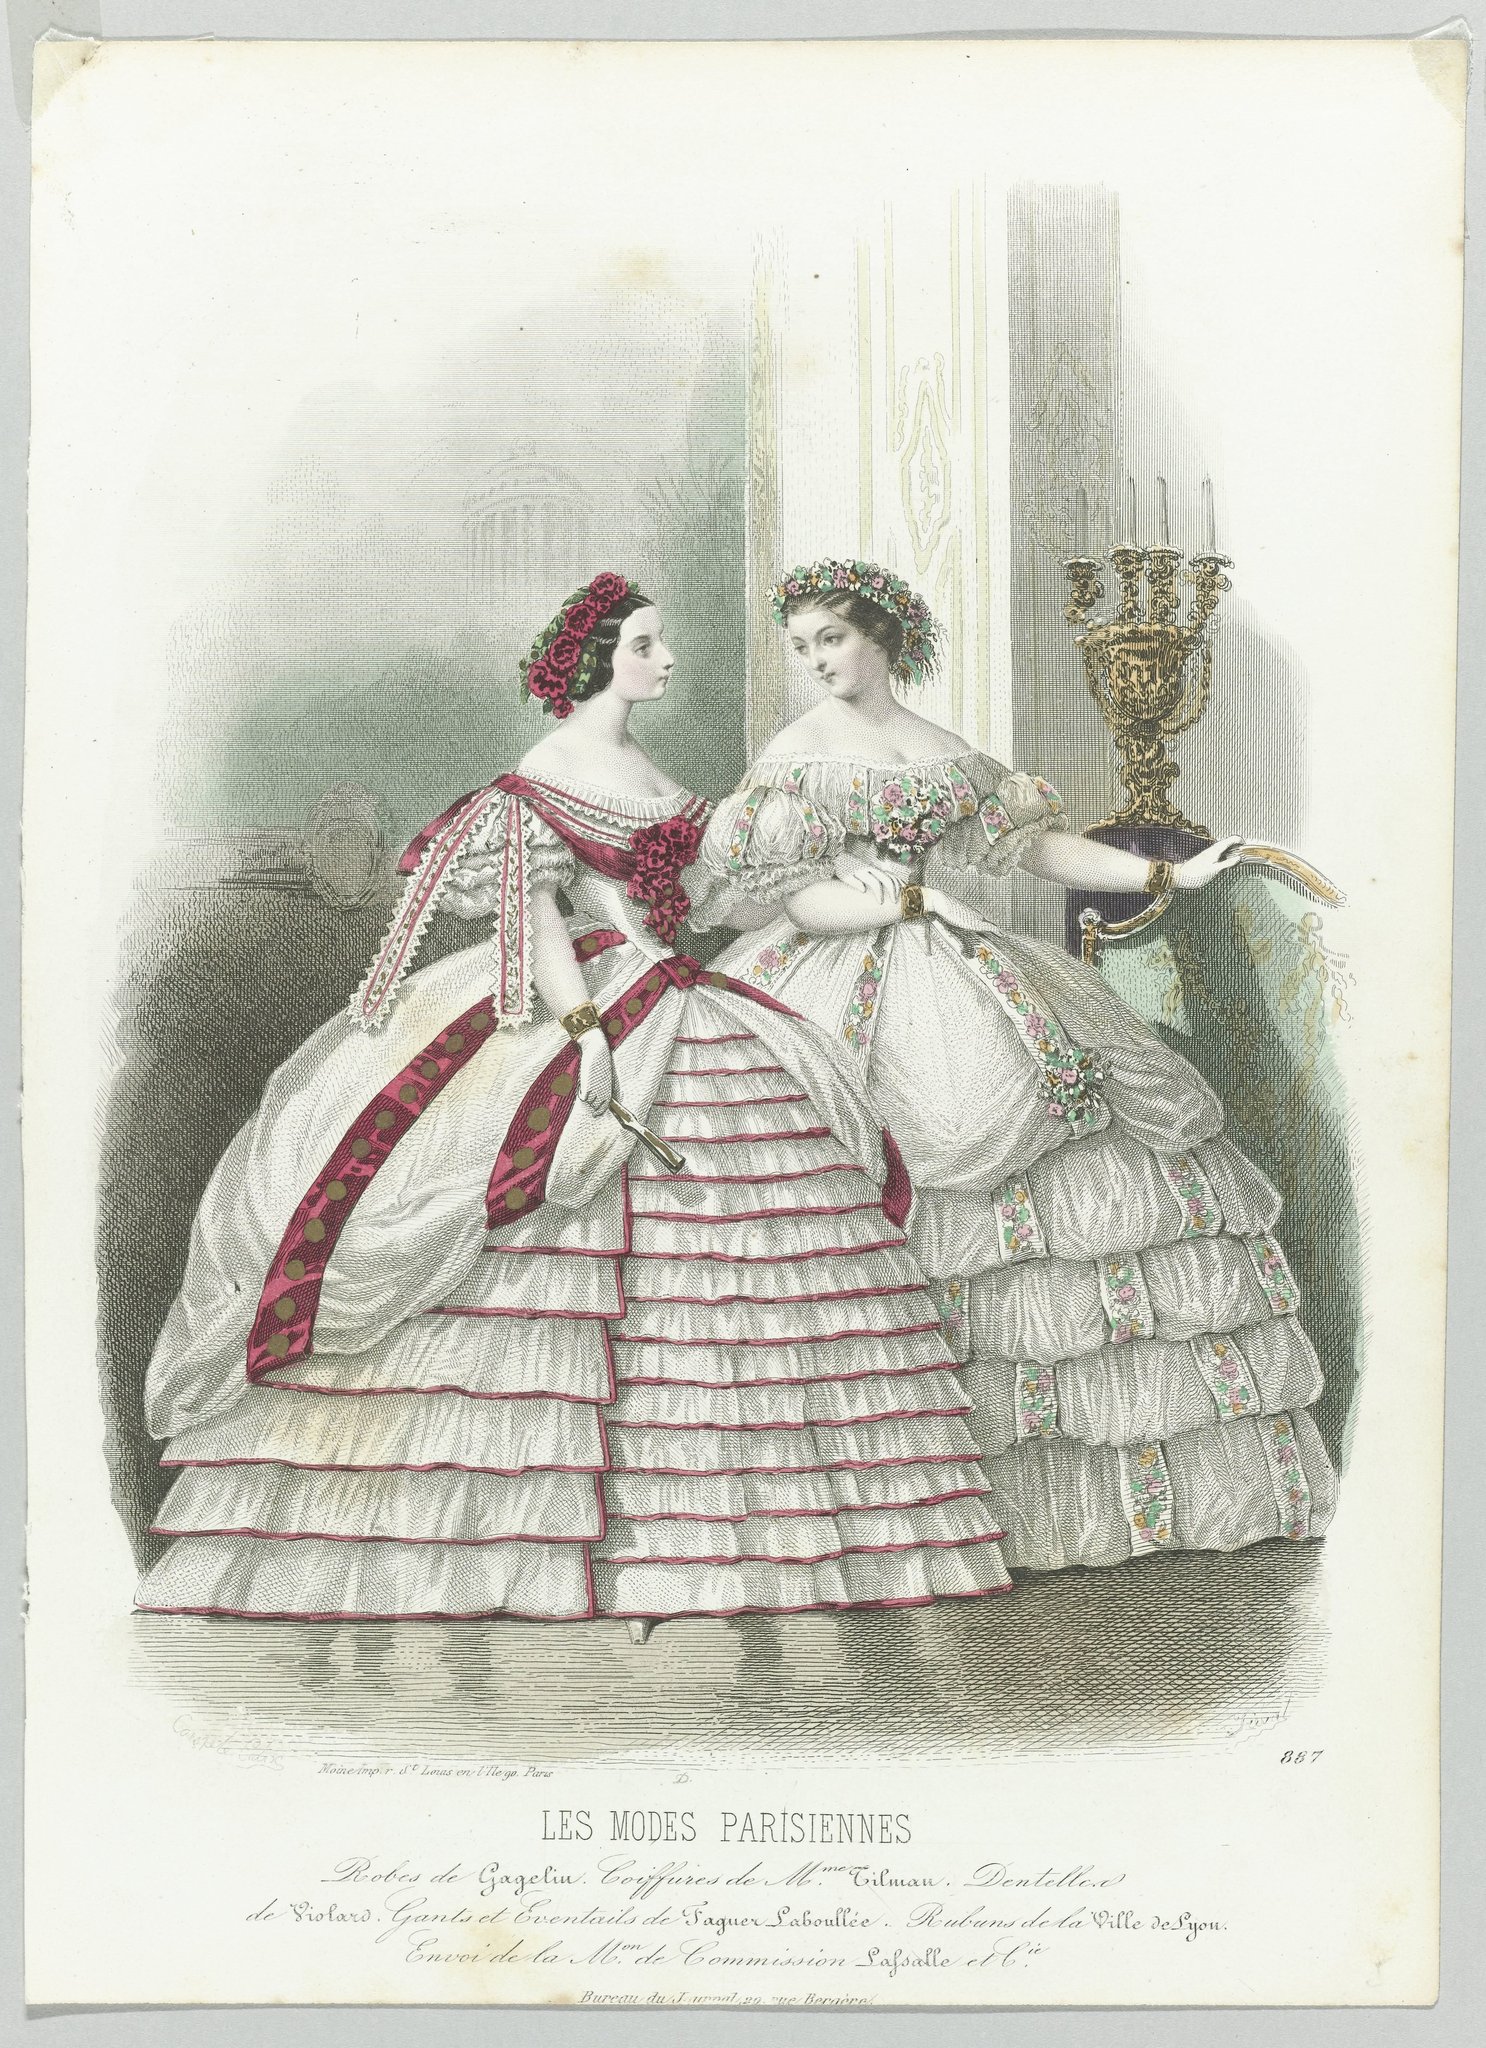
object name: fashion print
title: An Explosion of Fashion Magazines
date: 1860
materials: paper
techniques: engraving, hand coloring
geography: paris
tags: corsage (+ women's clothes), dress, gown: evening dress (+ women's clothes), lace (+ women's clothes), gloves, mittens (short gloves) (+ women's clothes), styles of hairdress - aa - ~ women, fashion plates, fan (+ women's clothes), bracelet, wristlet (+ women's clothes), necklace (+ women's clothes)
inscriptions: caption: ‘Robes de Gagelin. Coiffures de M.me Tilman. Dentelles de Violard. Gants et Eventails de Faguer Laboullée. Rubans de la Ville de Lyon. Envoi de la M.on de Commission Lassalle et C.ie.’, address: ‘Bureau du Journal, 20, rue Bergère.’, title: ‘Les Modes Parisiennes’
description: Starting from the 1850s, fashion magazines became more affordable and acquired a wider readership. The invention of the sewing machine around 1850 made it easier for people to make their own clothes. Ready-made garments were now also on offer, with fashion plates providing vendor addresses, such as the Maison Gagelin in Paris.